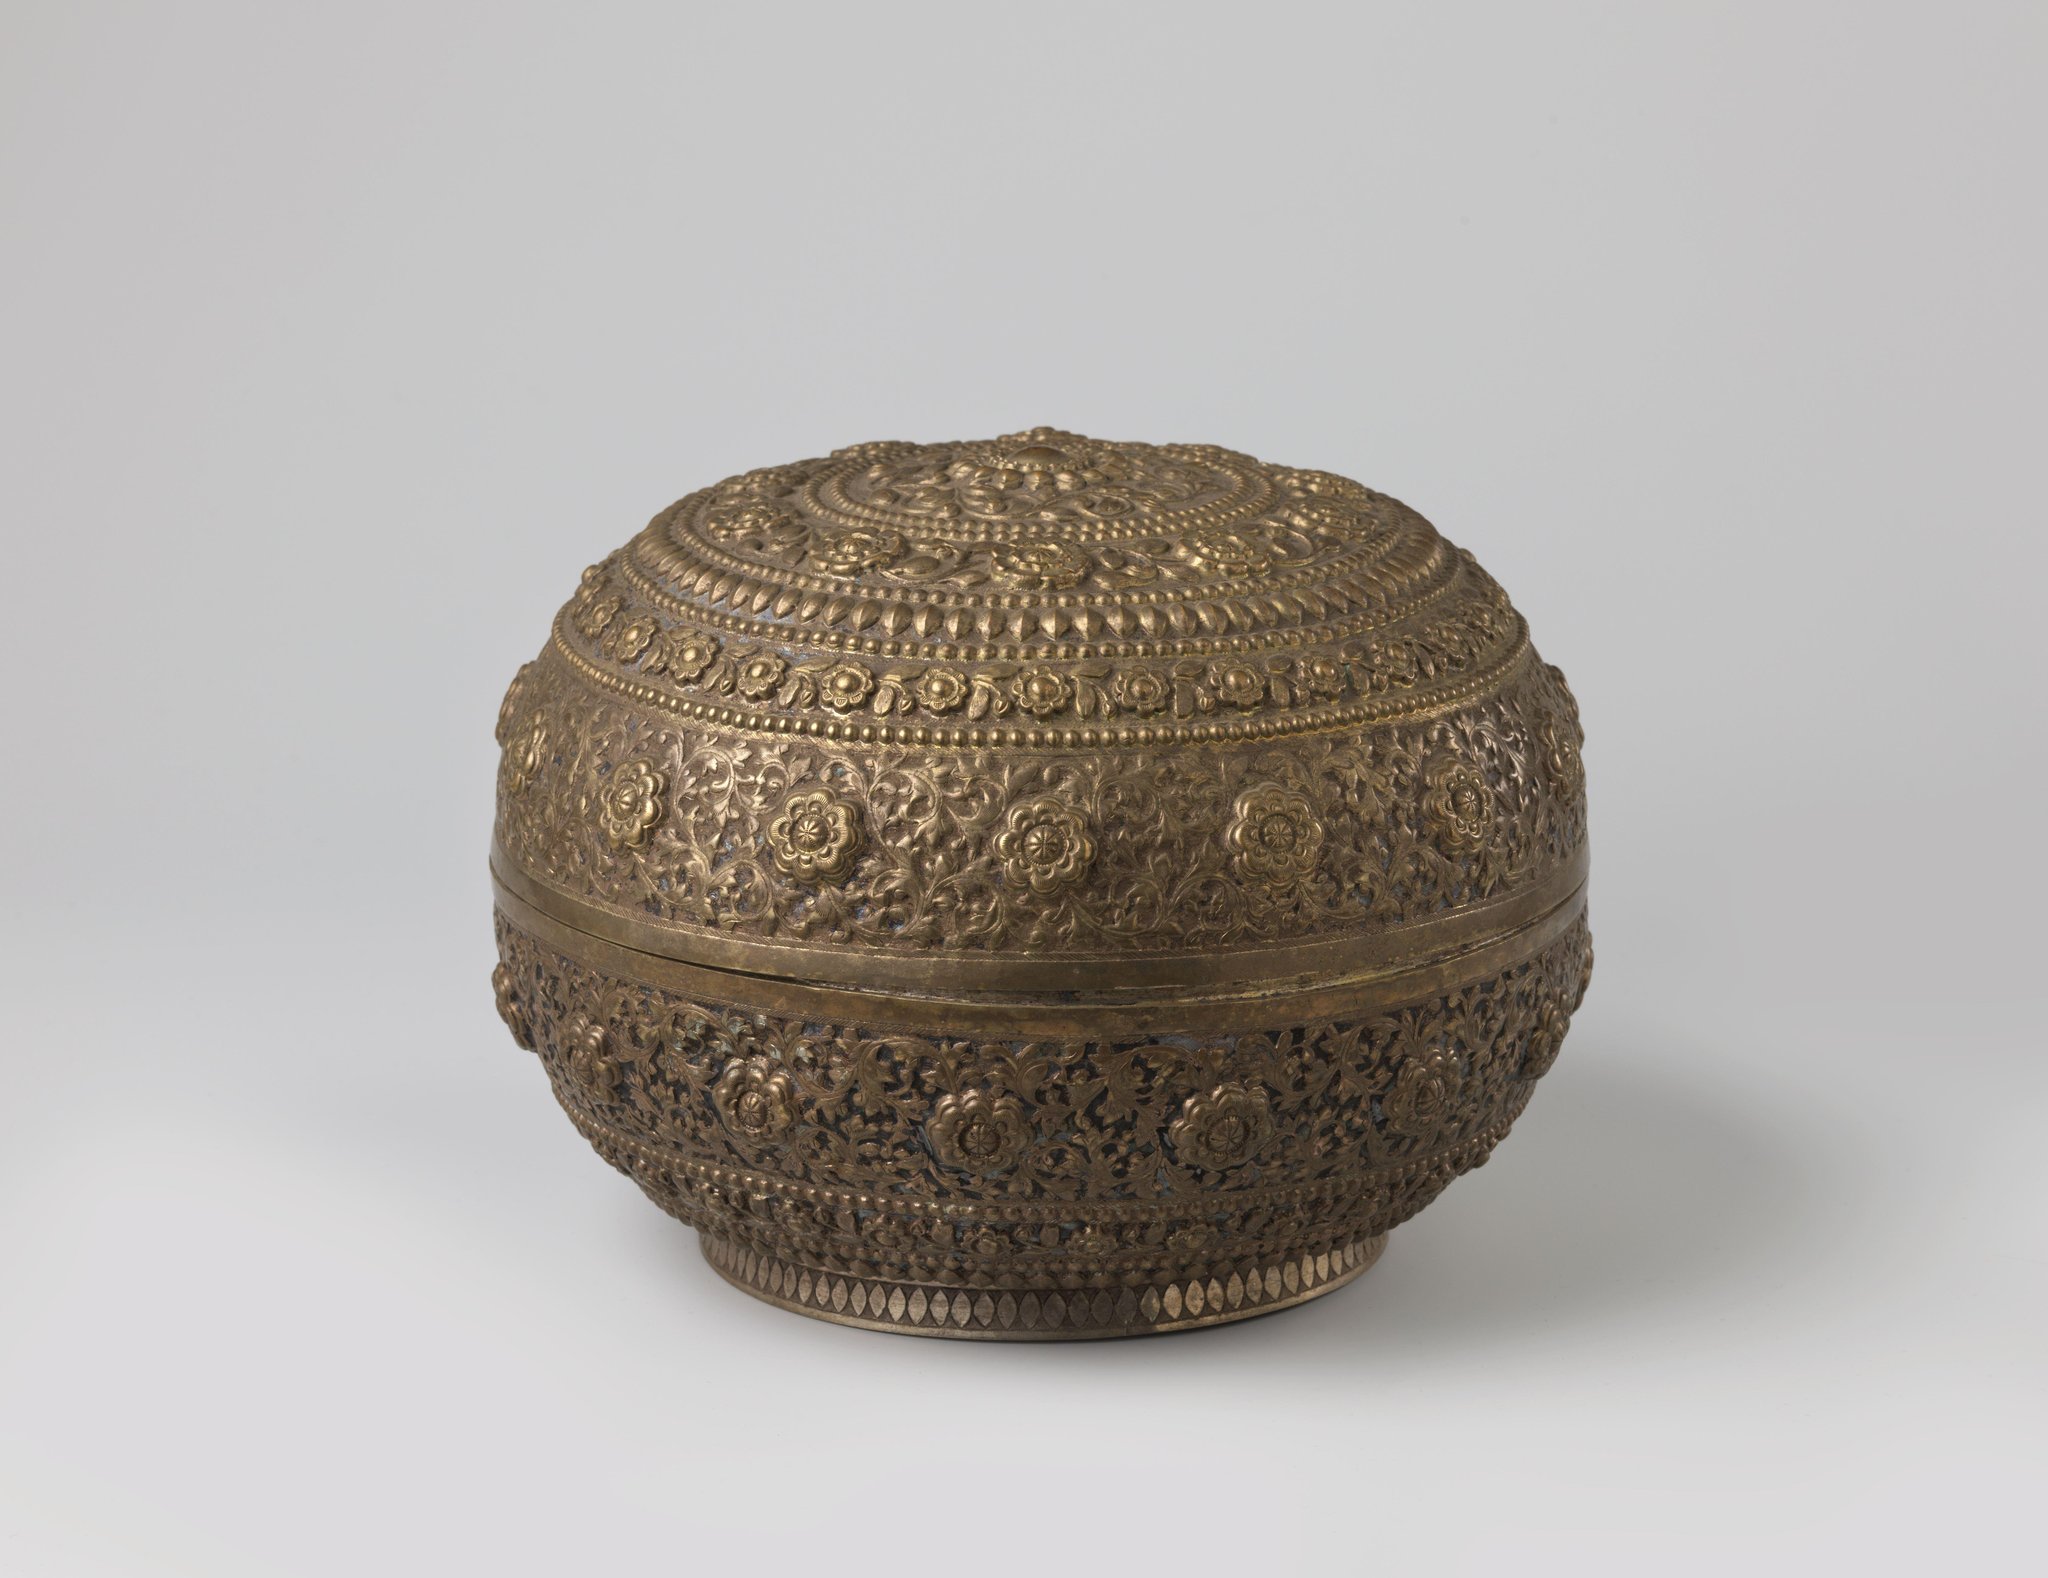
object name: box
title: Doos met deksel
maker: Anonymous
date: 1800-1900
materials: silver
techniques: repoussé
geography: riouw archipelago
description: Zilveren doos, rond, bolvormig, gedreven.